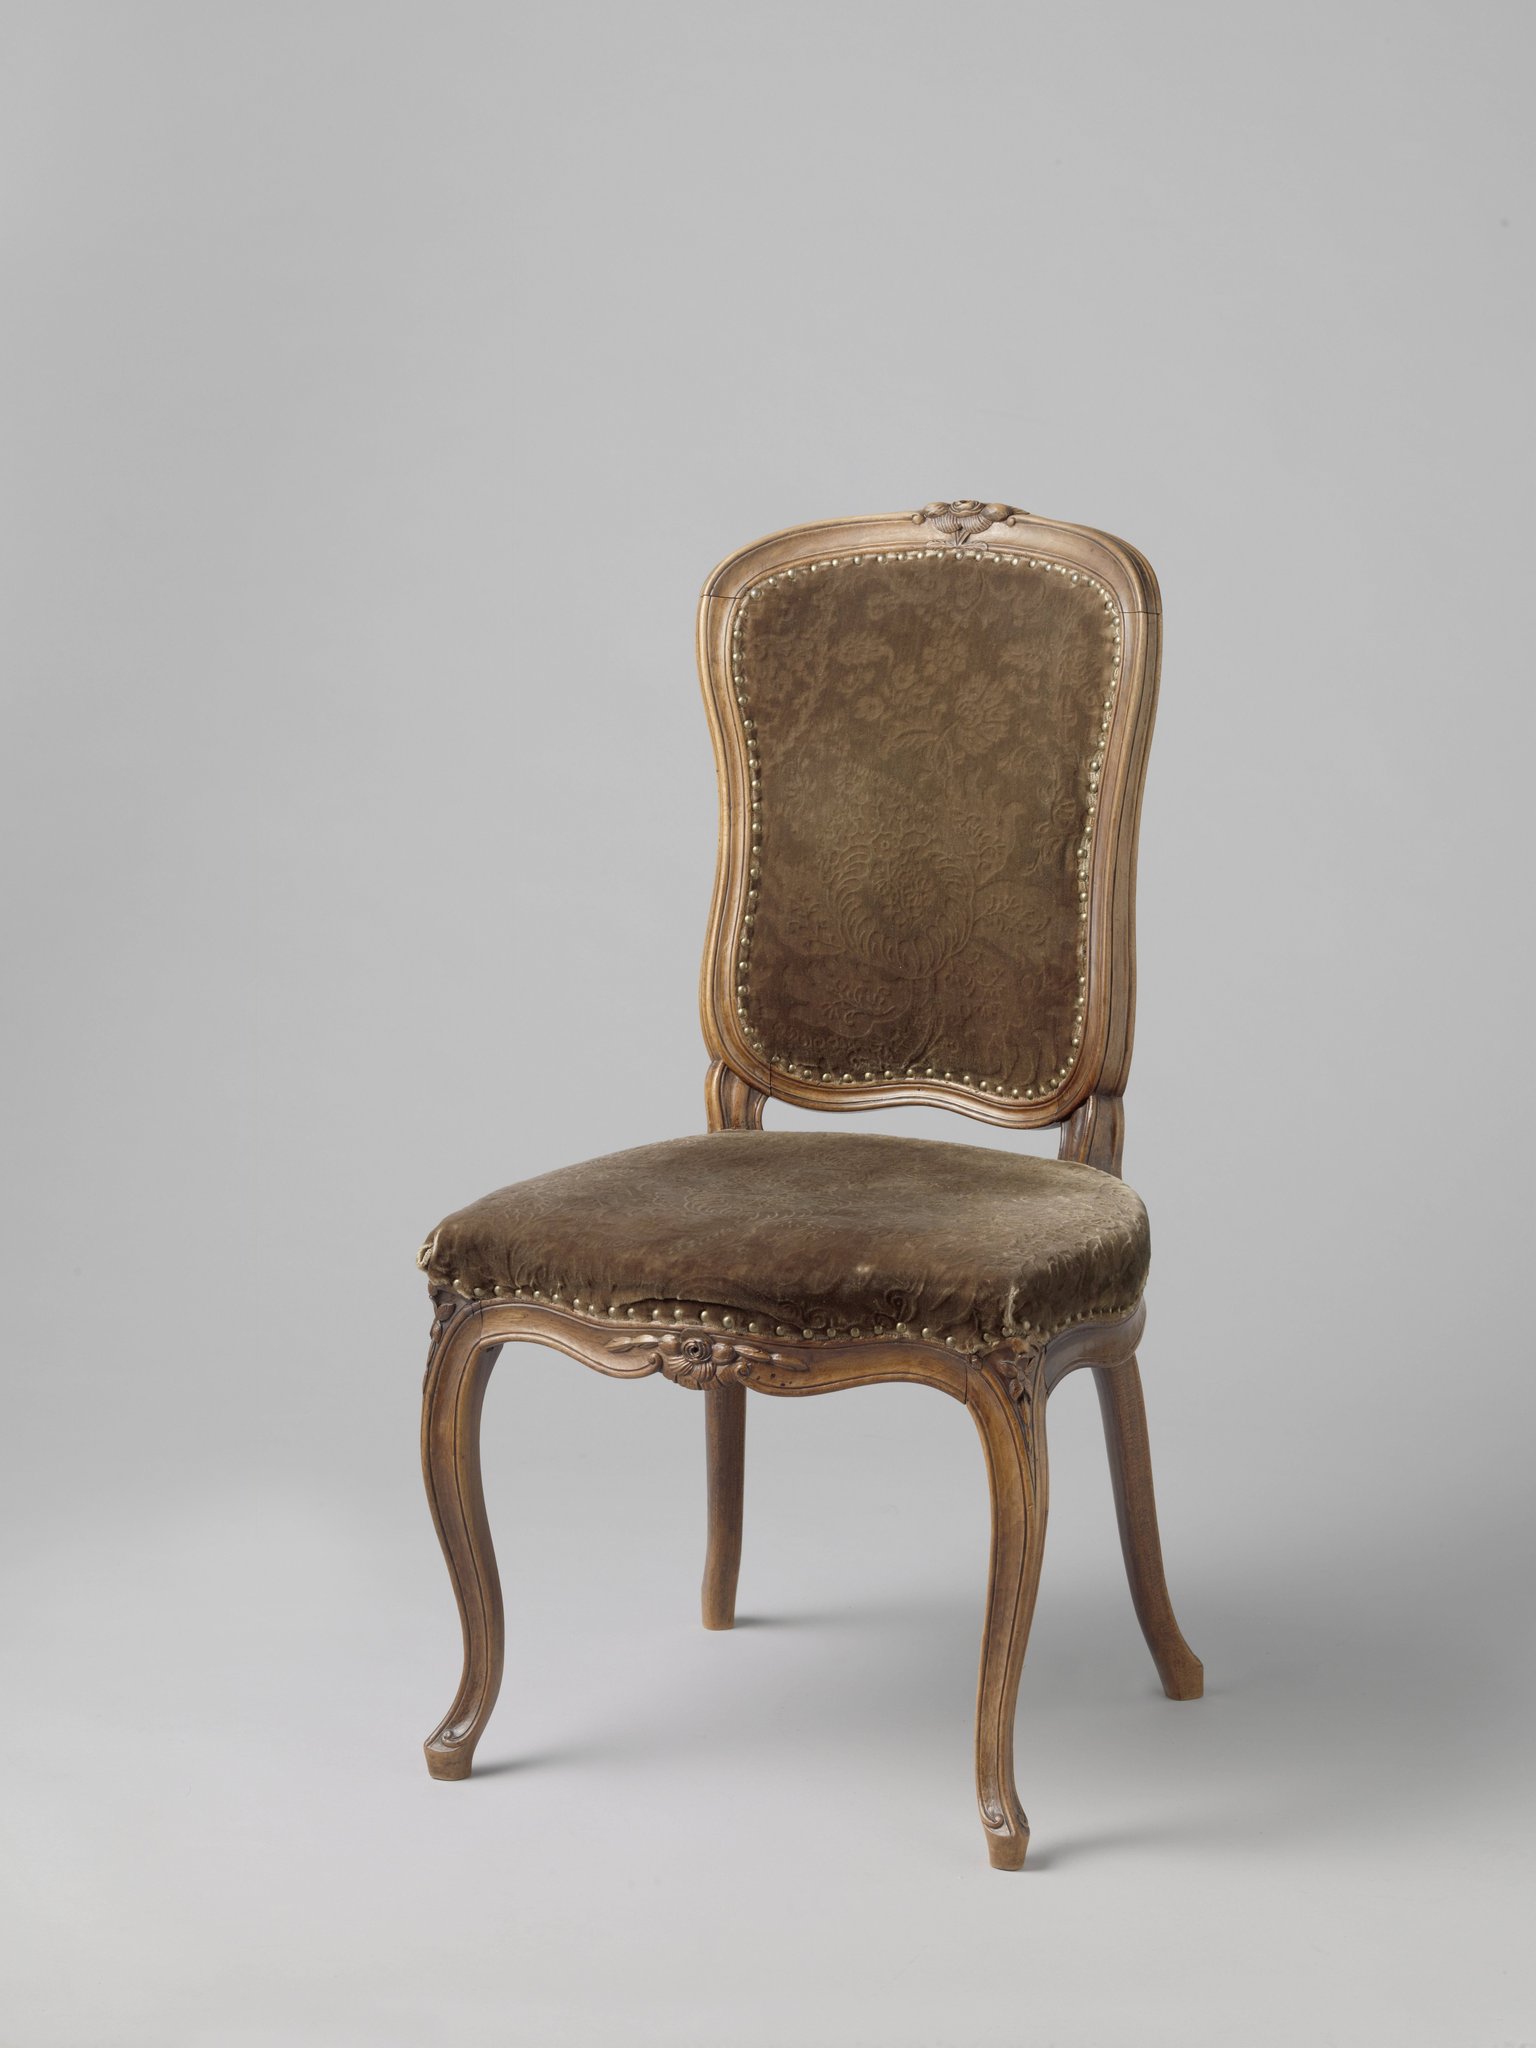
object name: seating furniture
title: Stoel met overhoeks geplaatste S-vormige poten op bokshoeven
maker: Anonymous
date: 1740-1760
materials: textile, wood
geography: northern netherlands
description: Stoel behorende tot ameublement bestaande uit zes beklede notenhouten stoelen en één armstoel, rustend op overhoeks geplaatste gestrekt S-vormige poten op bokshoeven, die in het zitraam overgaan. Het geronde, aan de voorkant geschulpte, zitraam draagt versieringen in bloemmotief; evenals de bovendorpel van het langwerpige beklede rugraam dat van onderen en van opzij iets geschulpt is. De gestrekt S-vormige armleggers worden gesteund door achterwaarts geplaatste gestrekt S-vormige stutten met voluut- en acanthusbladversiering.